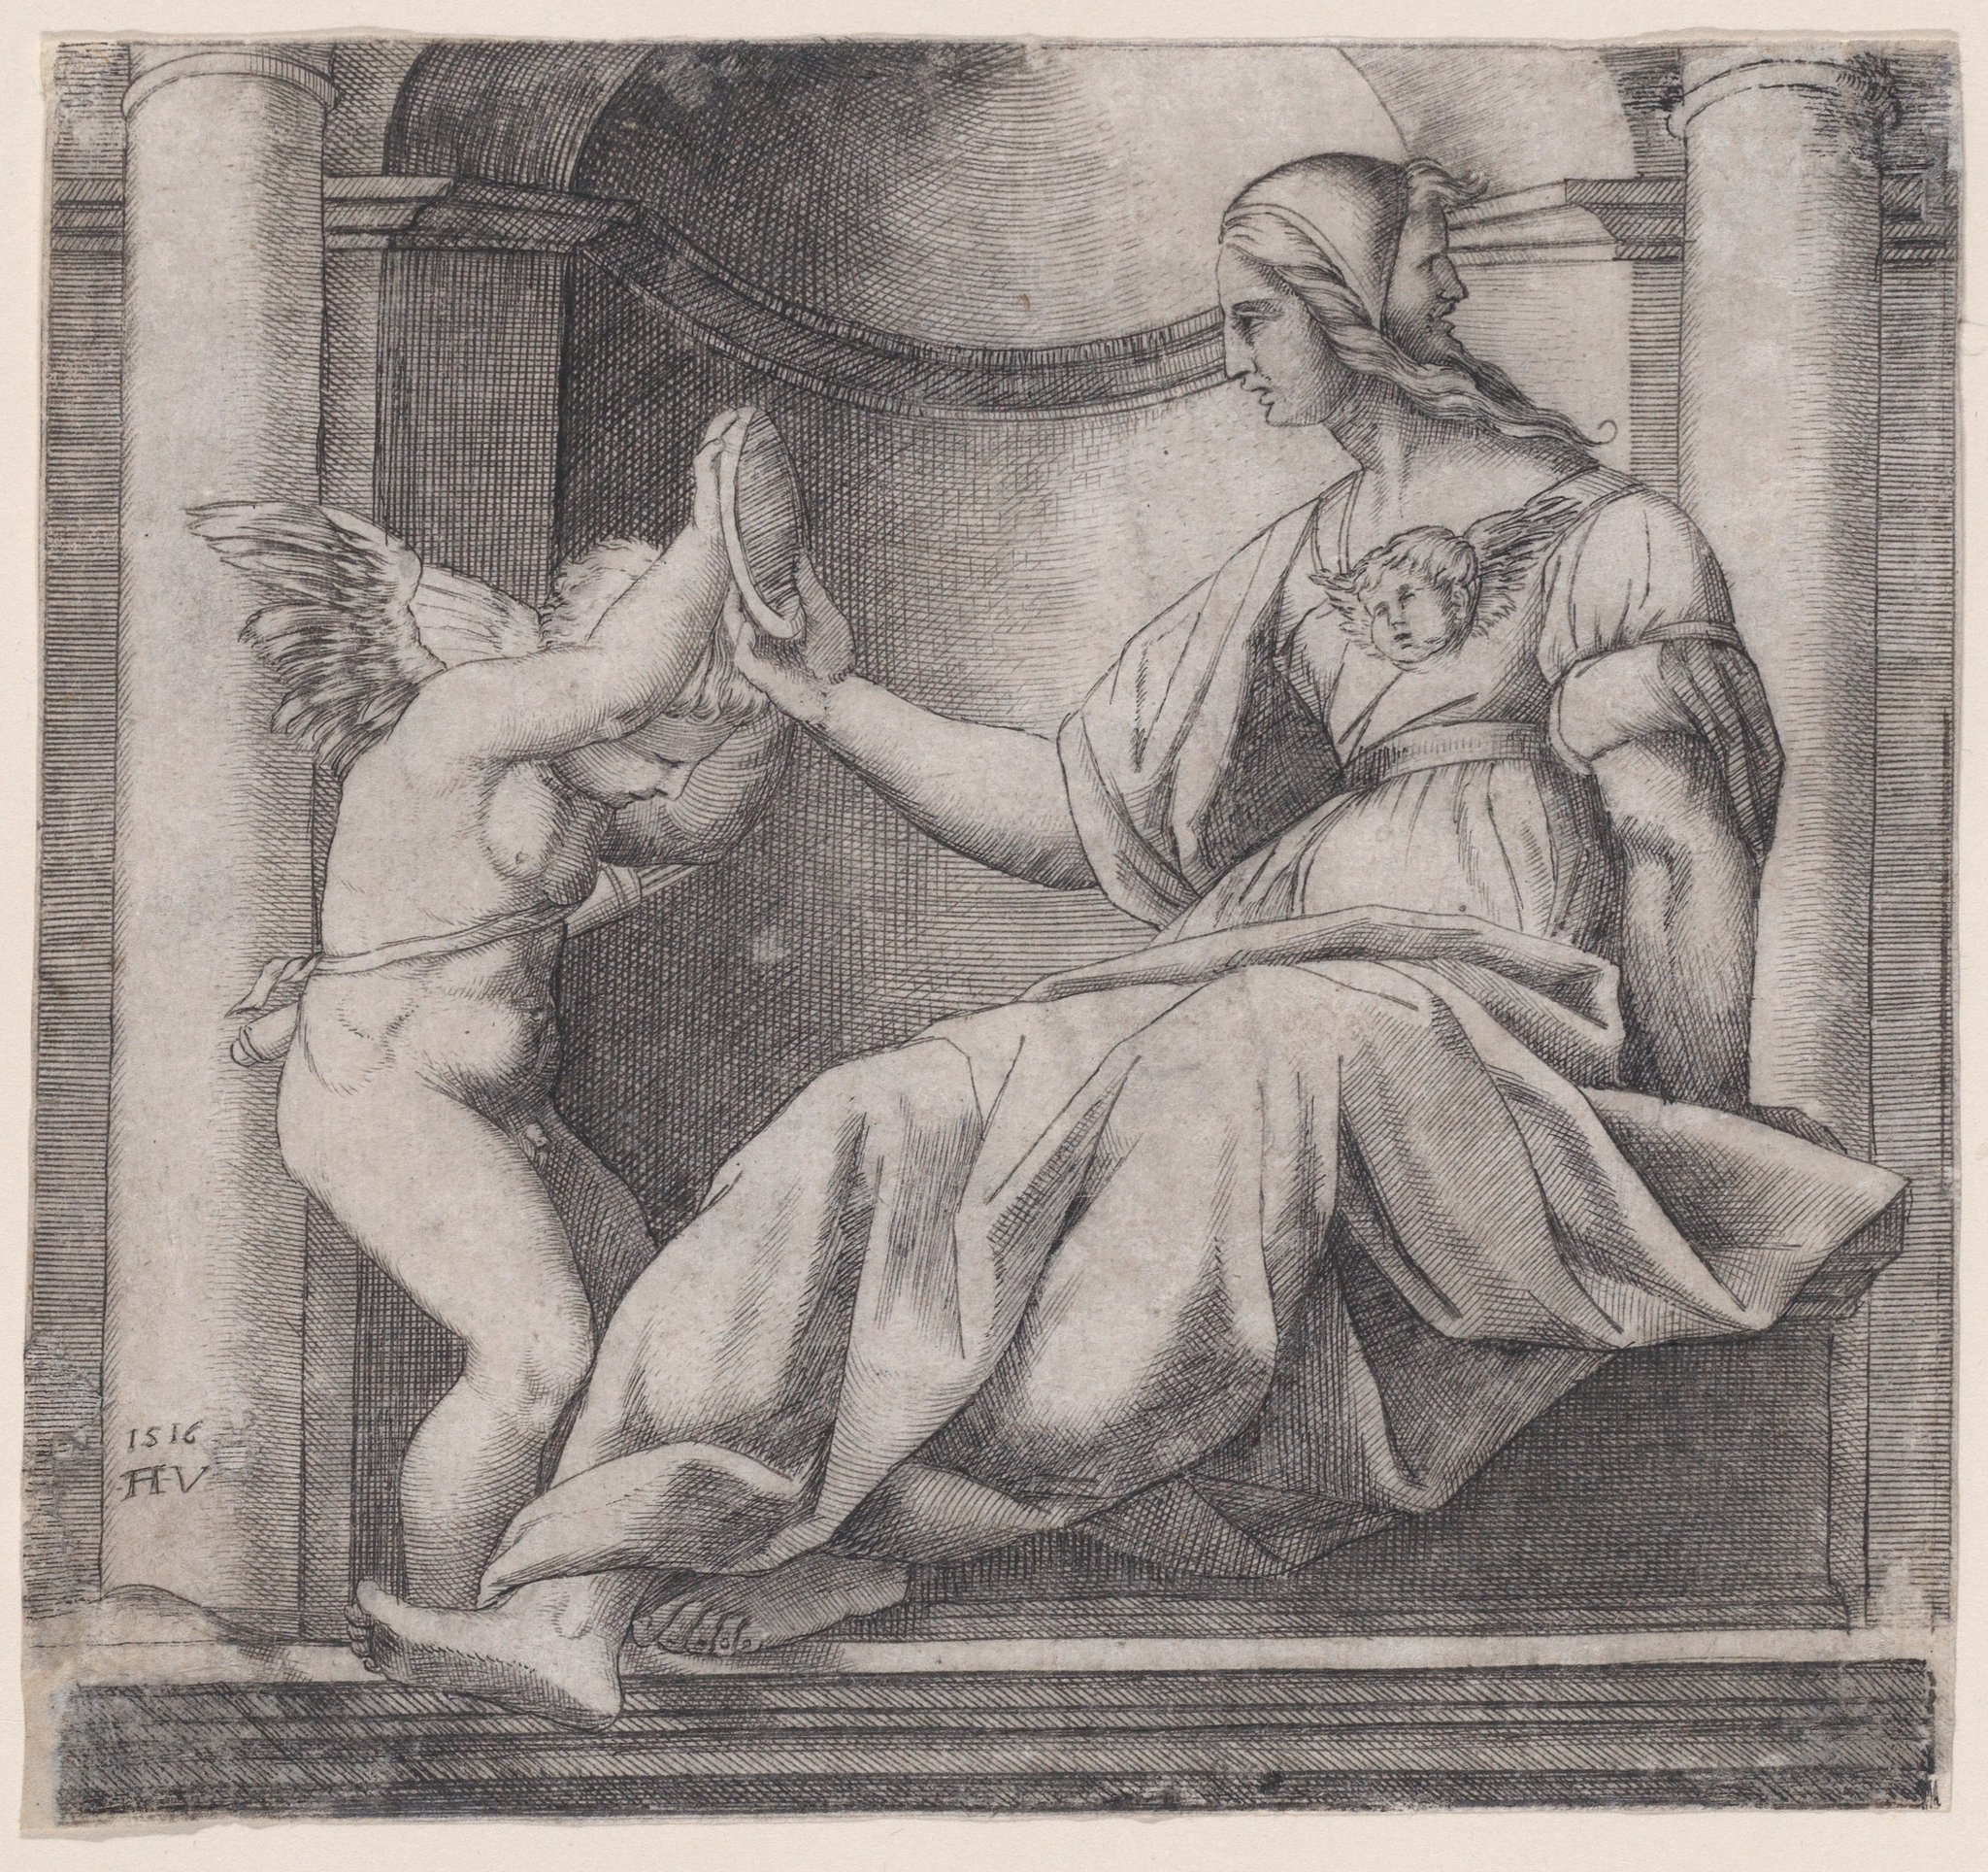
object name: print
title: Prudence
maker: agostino veneziano (agostino dei musi)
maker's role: artist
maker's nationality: italian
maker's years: 1490-1536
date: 1516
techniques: engraving